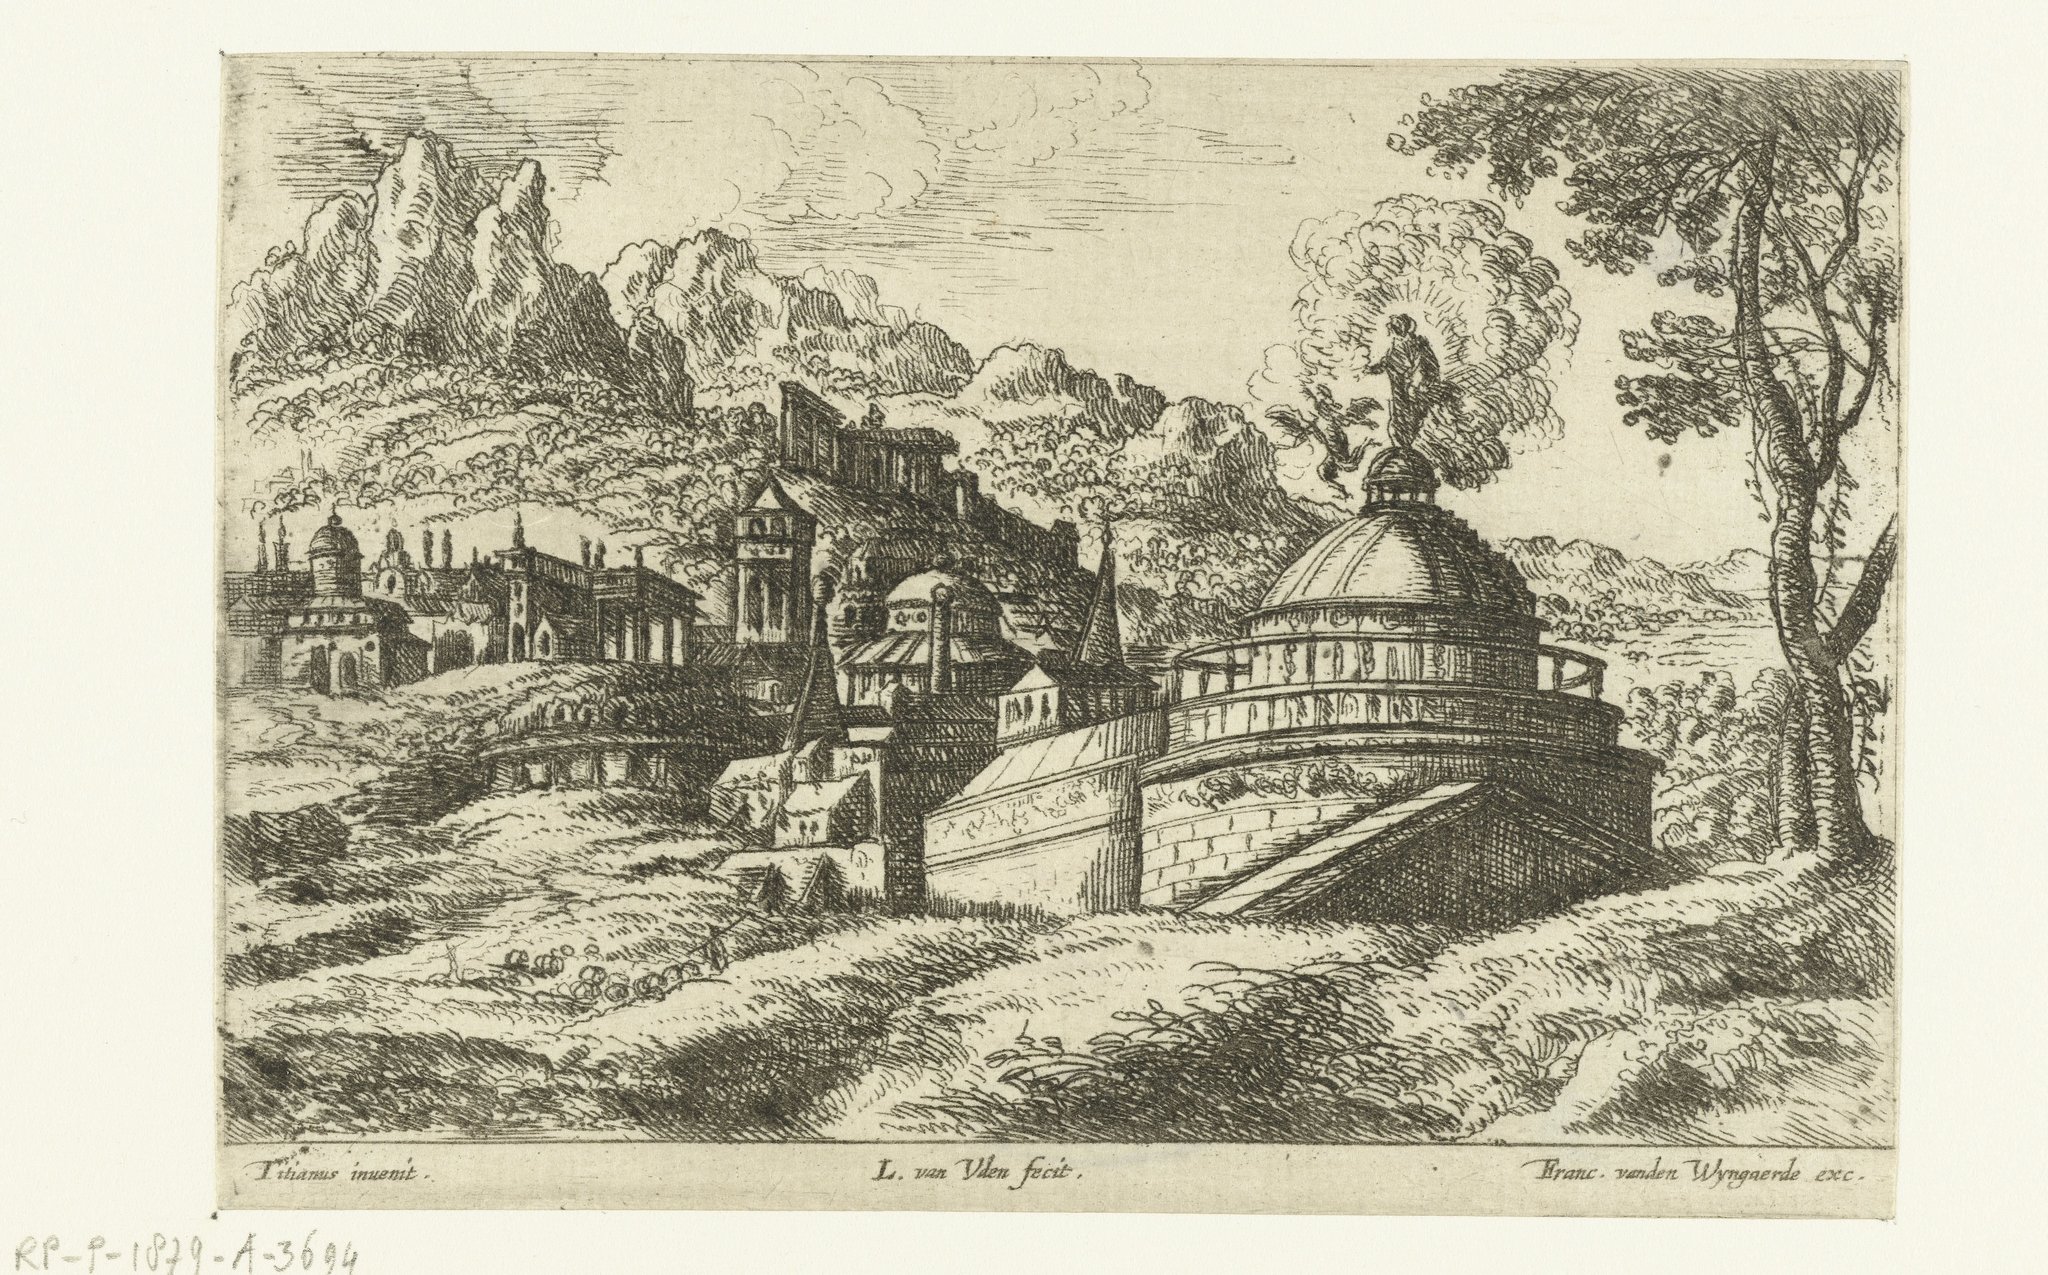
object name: print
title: Kleine landschappen naar Titiaan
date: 1605-1723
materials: paper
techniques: etching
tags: city-view in general; 'veduta', satan withdrawing from christ ~ temptation of christ in the wilderness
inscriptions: collector's mark: Lugt 2228, collector's mark: Lugt 1407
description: Kopie in spiegelbeeld. Landschap met een immaginaire antieke stad, op de koepel van een gebouw Christus en een duivel.